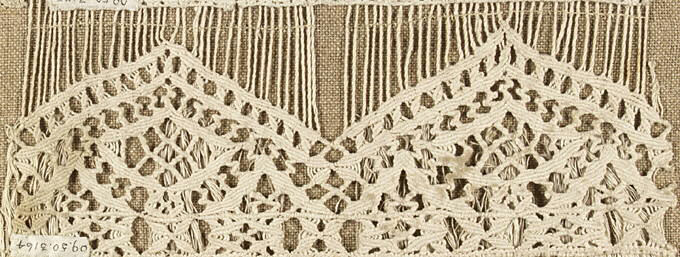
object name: fragment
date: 1701-1800